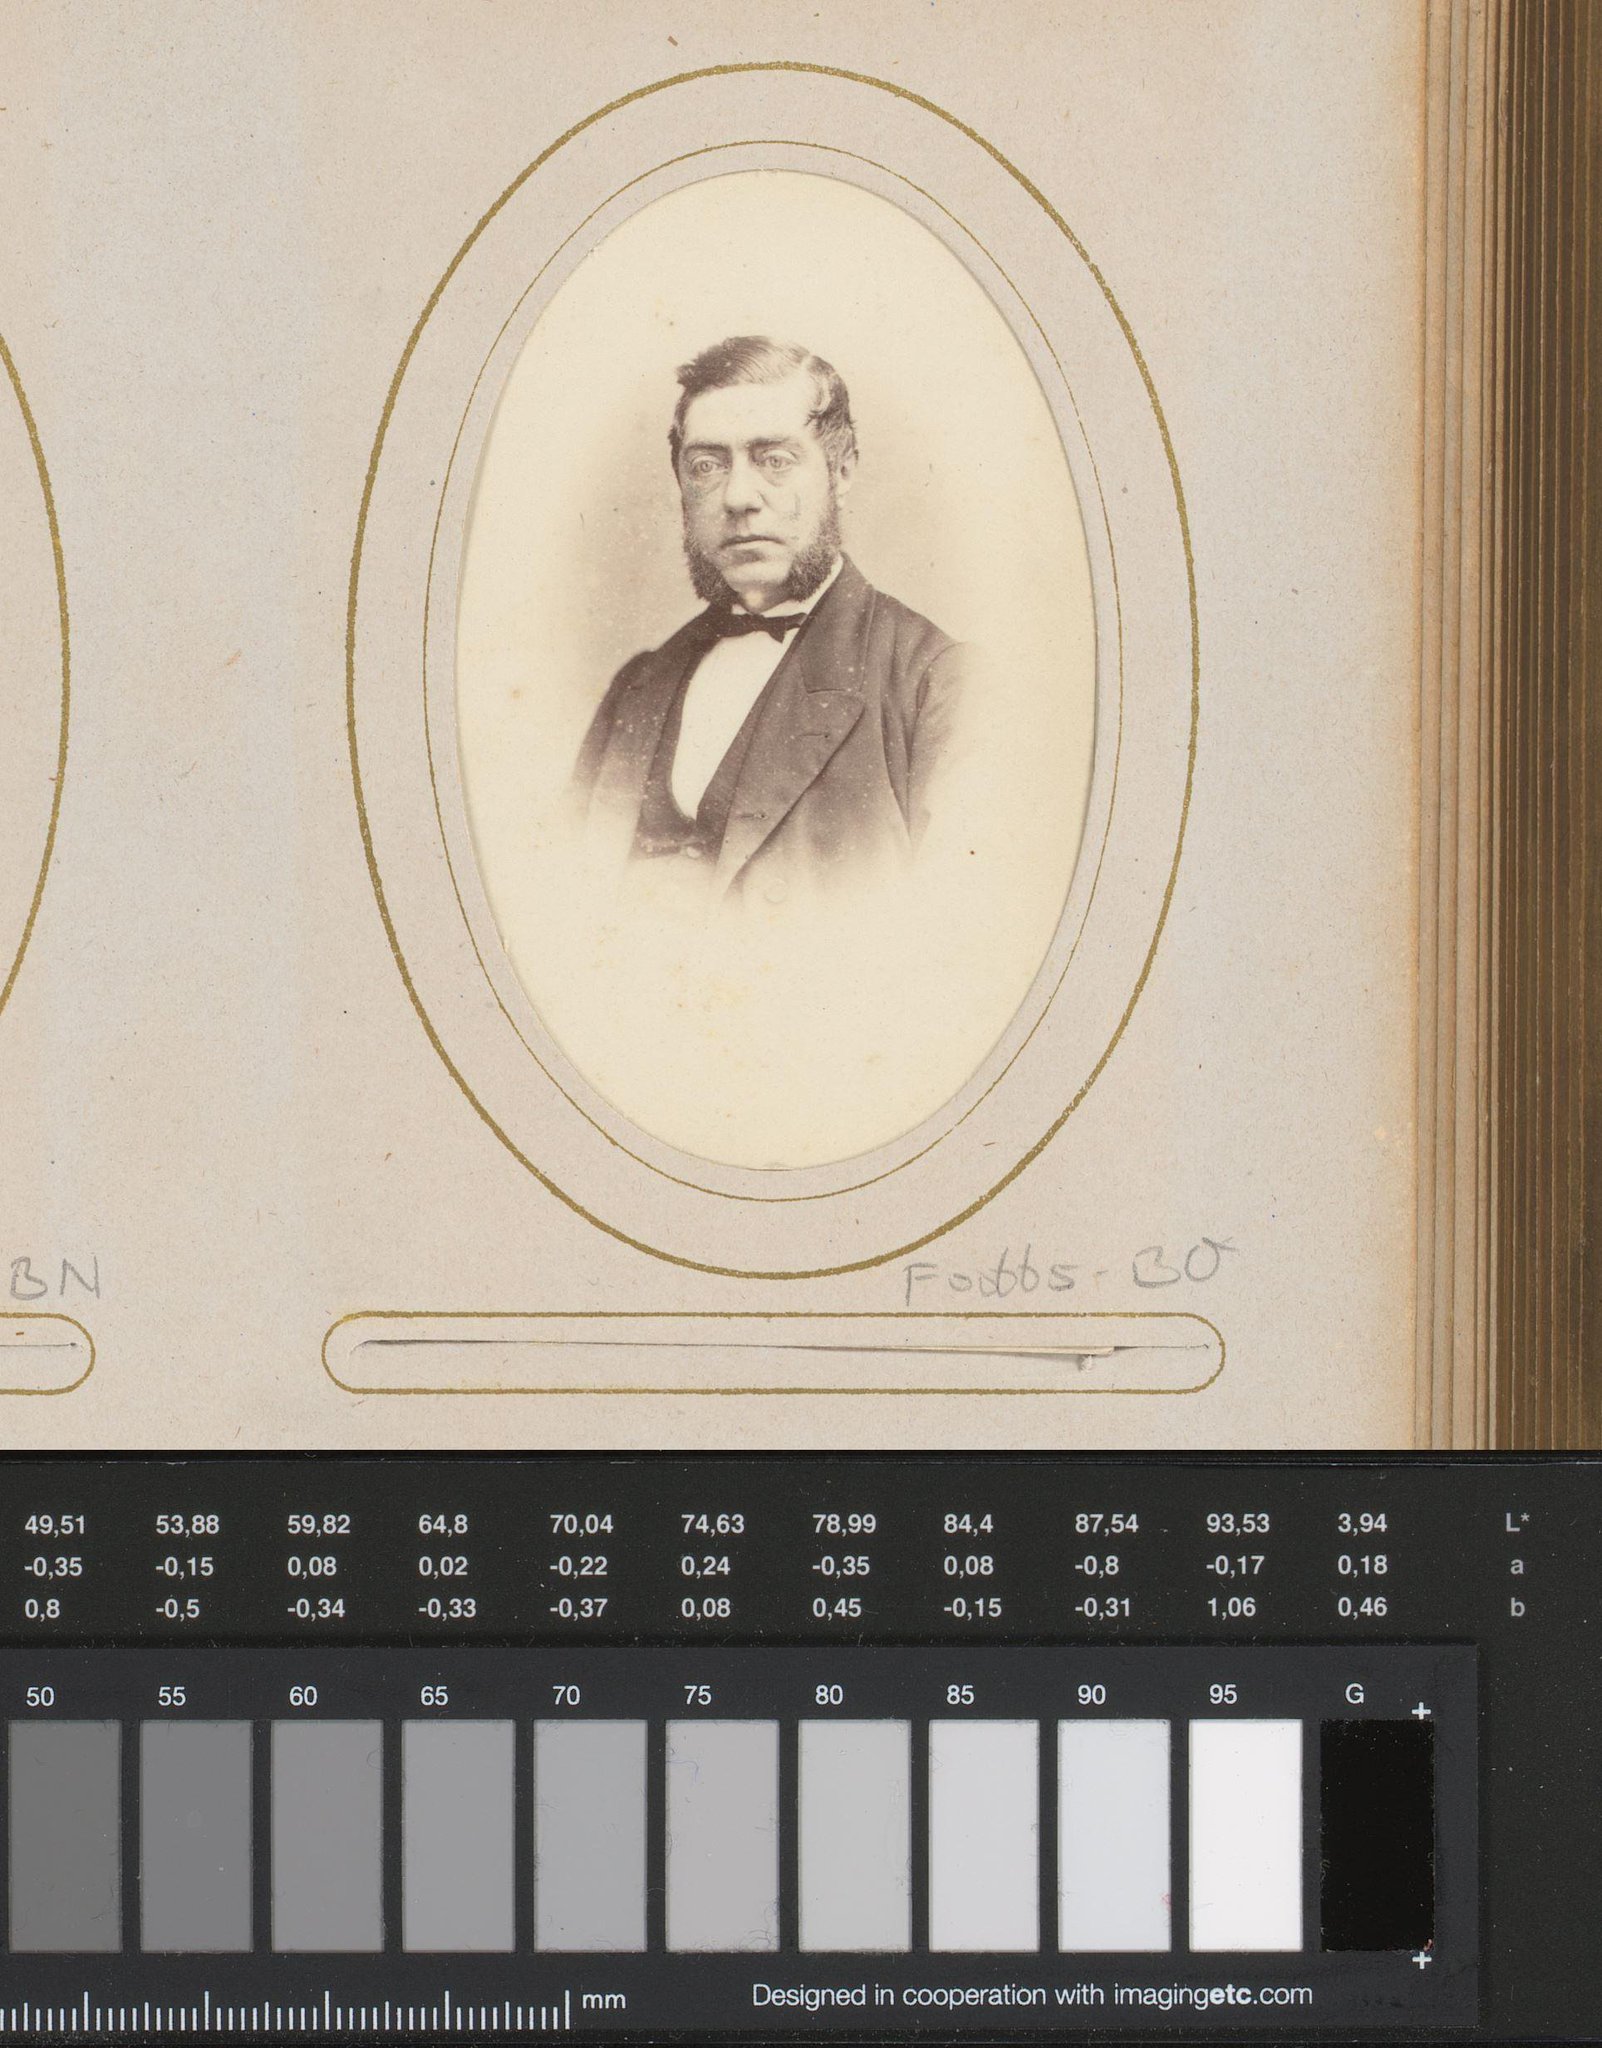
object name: carte de visite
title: Portret van een man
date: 1865-1890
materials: cardboard, photographic support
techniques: albumen print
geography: amsterdam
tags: historical persons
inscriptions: inscription: ‘Photogr Atelier/ Wegner & Mottu/ Kalverstraat/ Over den Heyligenweg D.26/ Amsterdam’